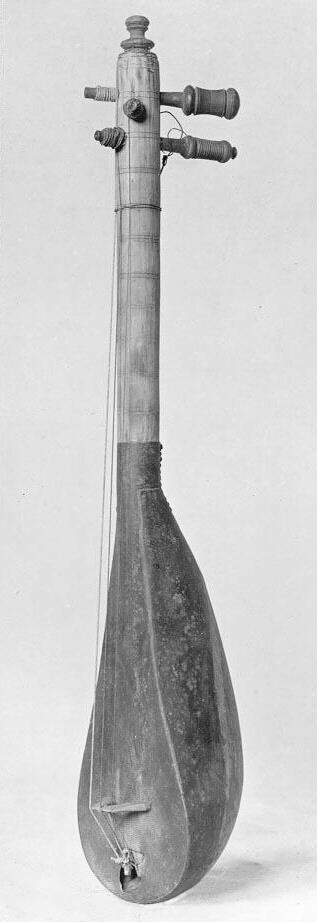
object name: guenbri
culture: moroccan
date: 1867-1900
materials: parchment, wood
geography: morocco